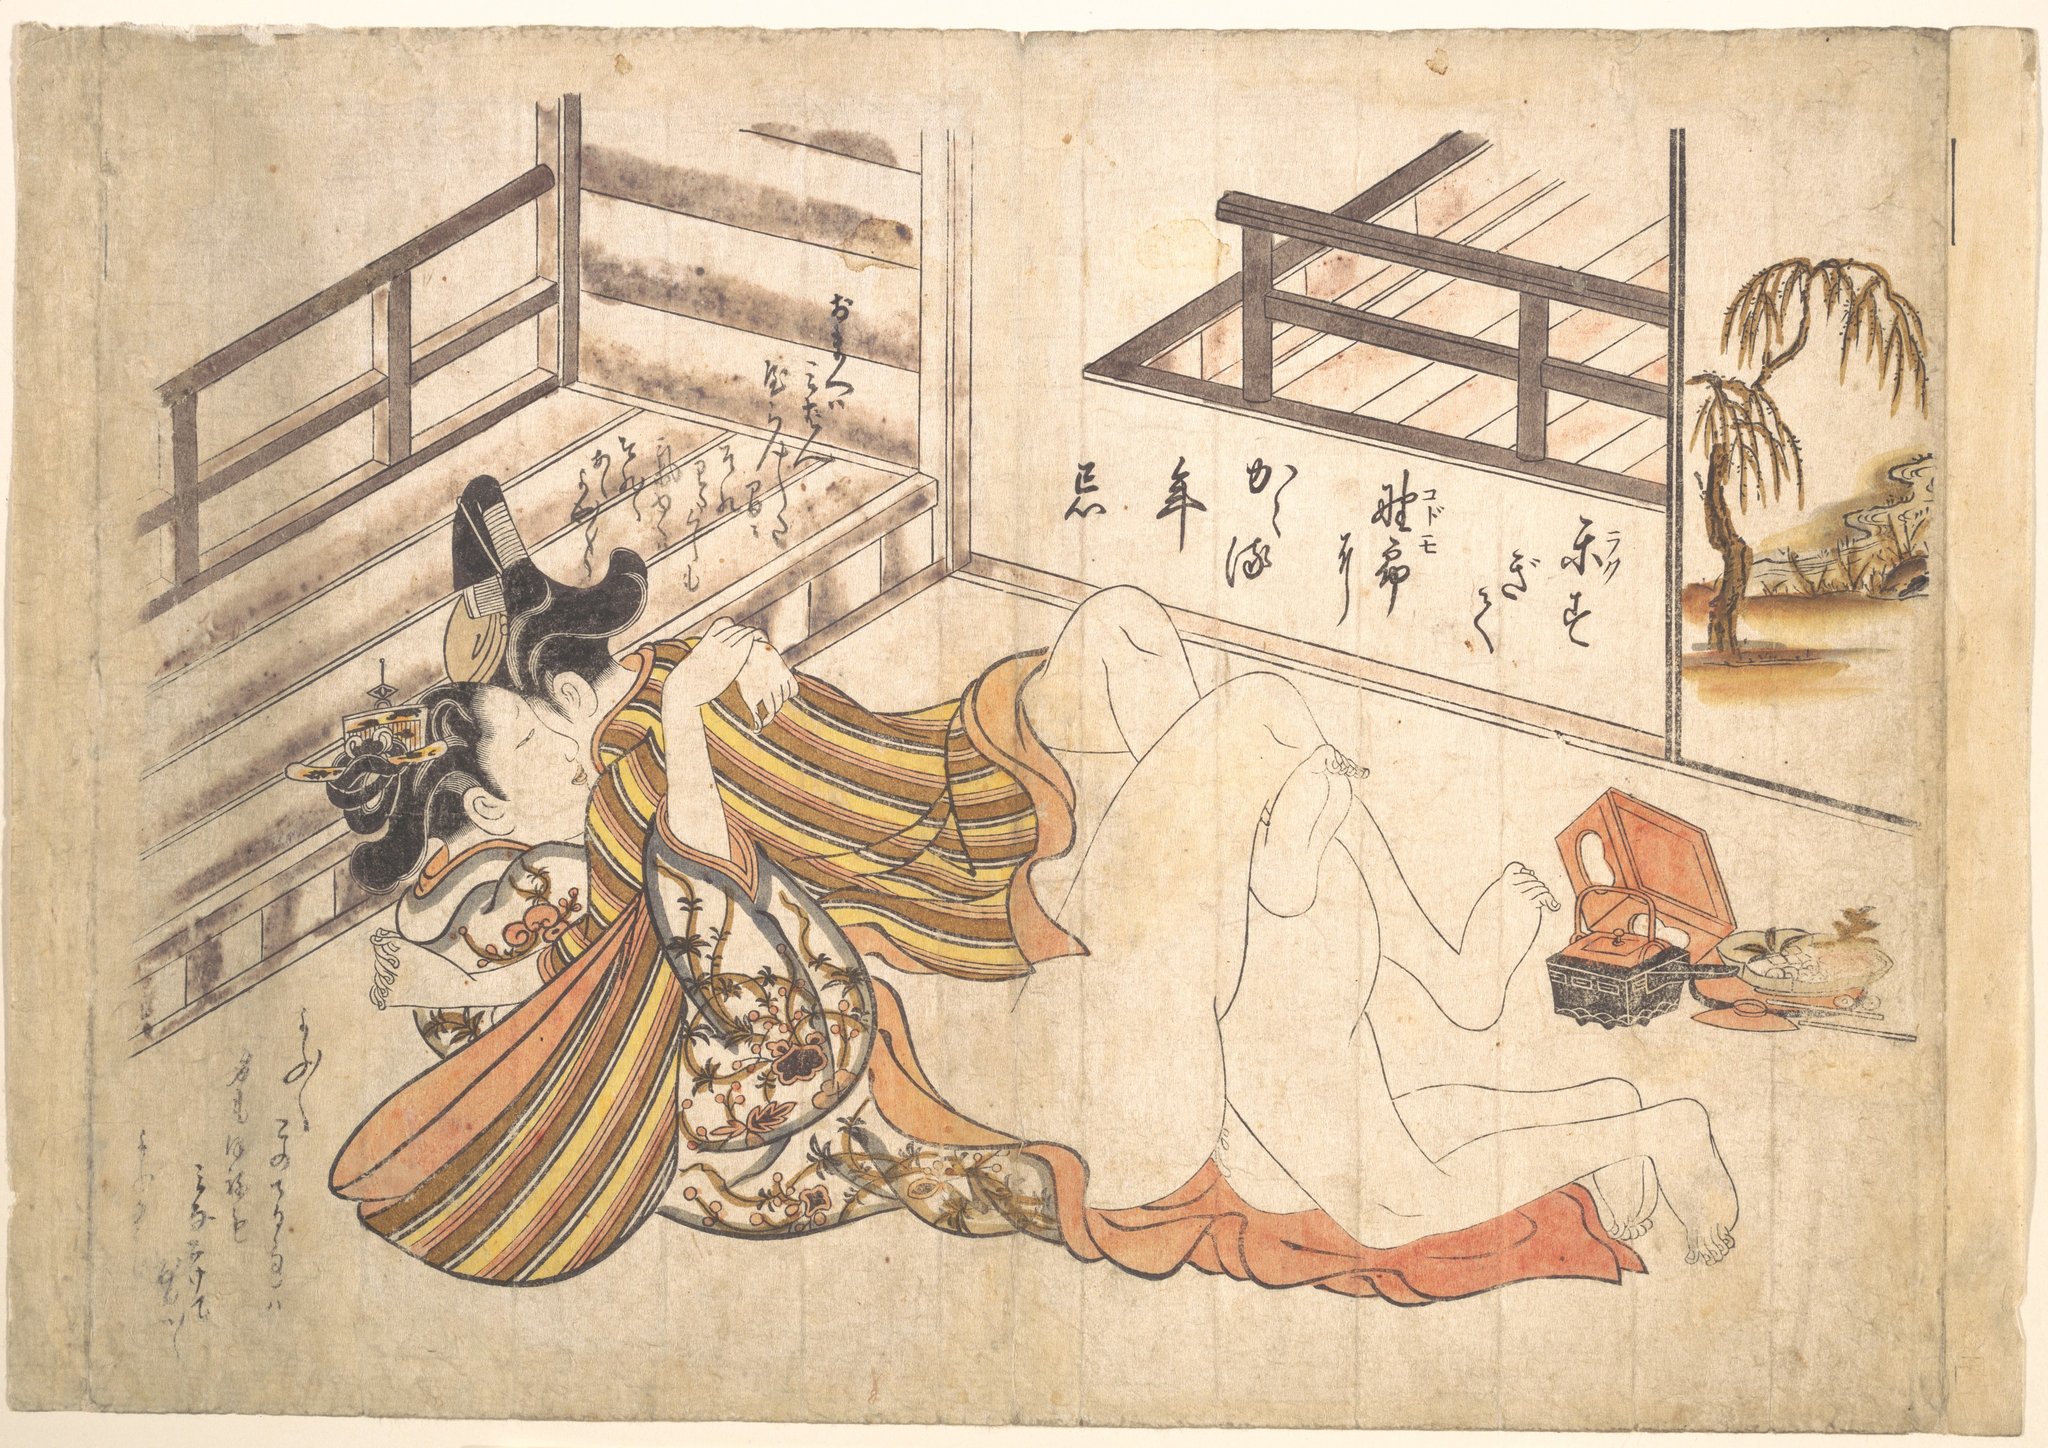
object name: print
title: Bedroom Scene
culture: japanese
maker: okumura masanobu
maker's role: artist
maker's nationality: japanese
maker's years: 1686-1764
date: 1739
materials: ink, paper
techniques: hand coloring, woodblock print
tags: bedrooms,men,women